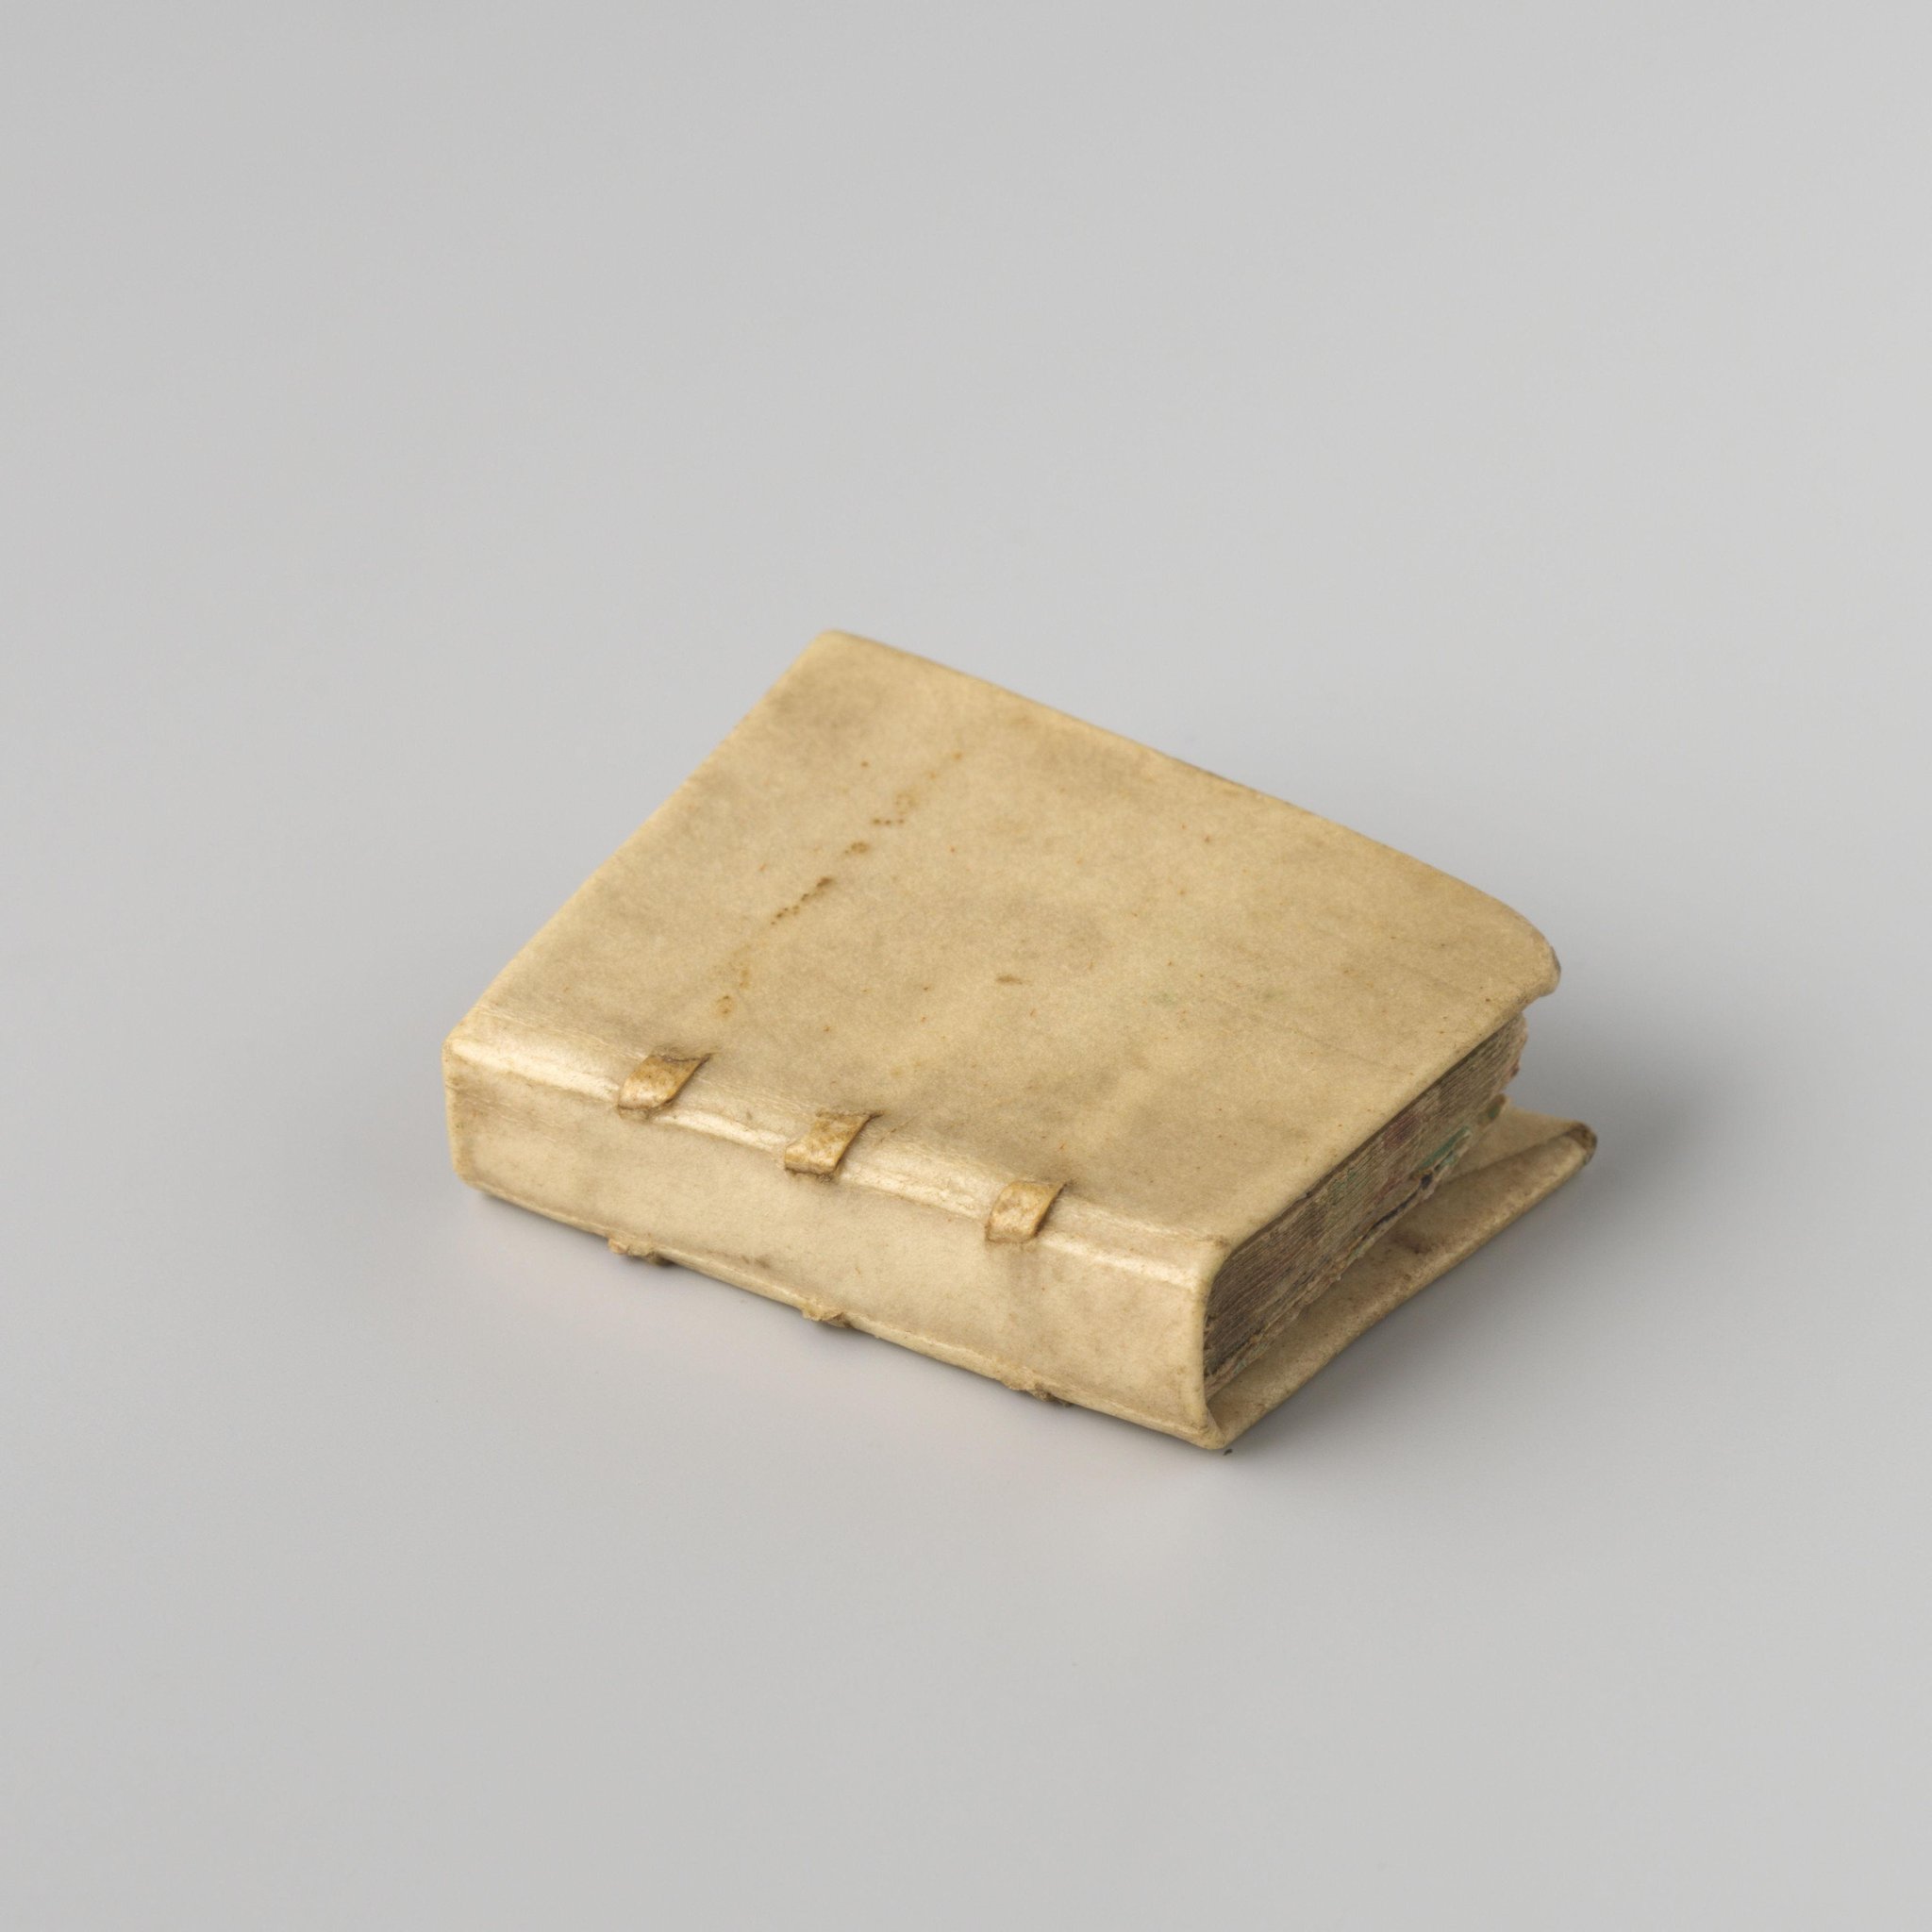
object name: miniature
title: Wapenboek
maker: jacobus robijn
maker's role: print maker, publisher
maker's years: -1707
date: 1673-1707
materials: paper, parchment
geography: amsterdam